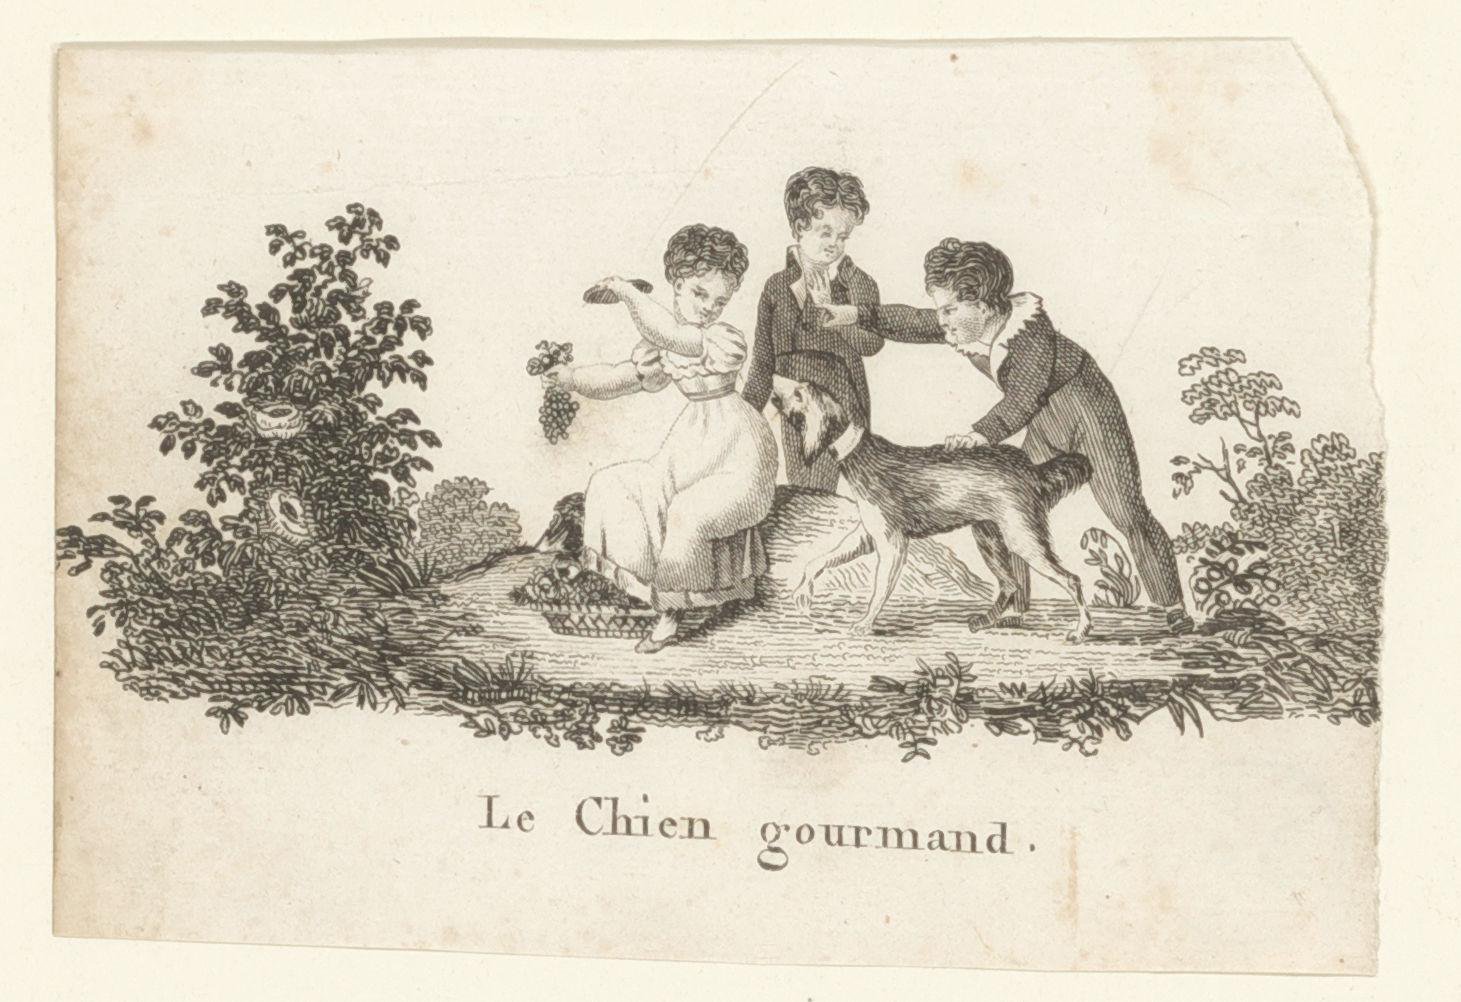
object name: print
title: Drie kinderen spelen met een hond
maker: Anonymous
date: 1800-1899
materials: paper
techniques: etching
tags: children's games and plays, dog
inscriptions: collector's mark: Lugt 1641, stamp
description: Onderwerpsrubrieken binnen de Atlas Zeden en Gewoonten: Zeden en Gewoonten in Engeren Zin, Des menschen beging, midden en einde, Kinderleven – Kinderspel en Kinderprenten.